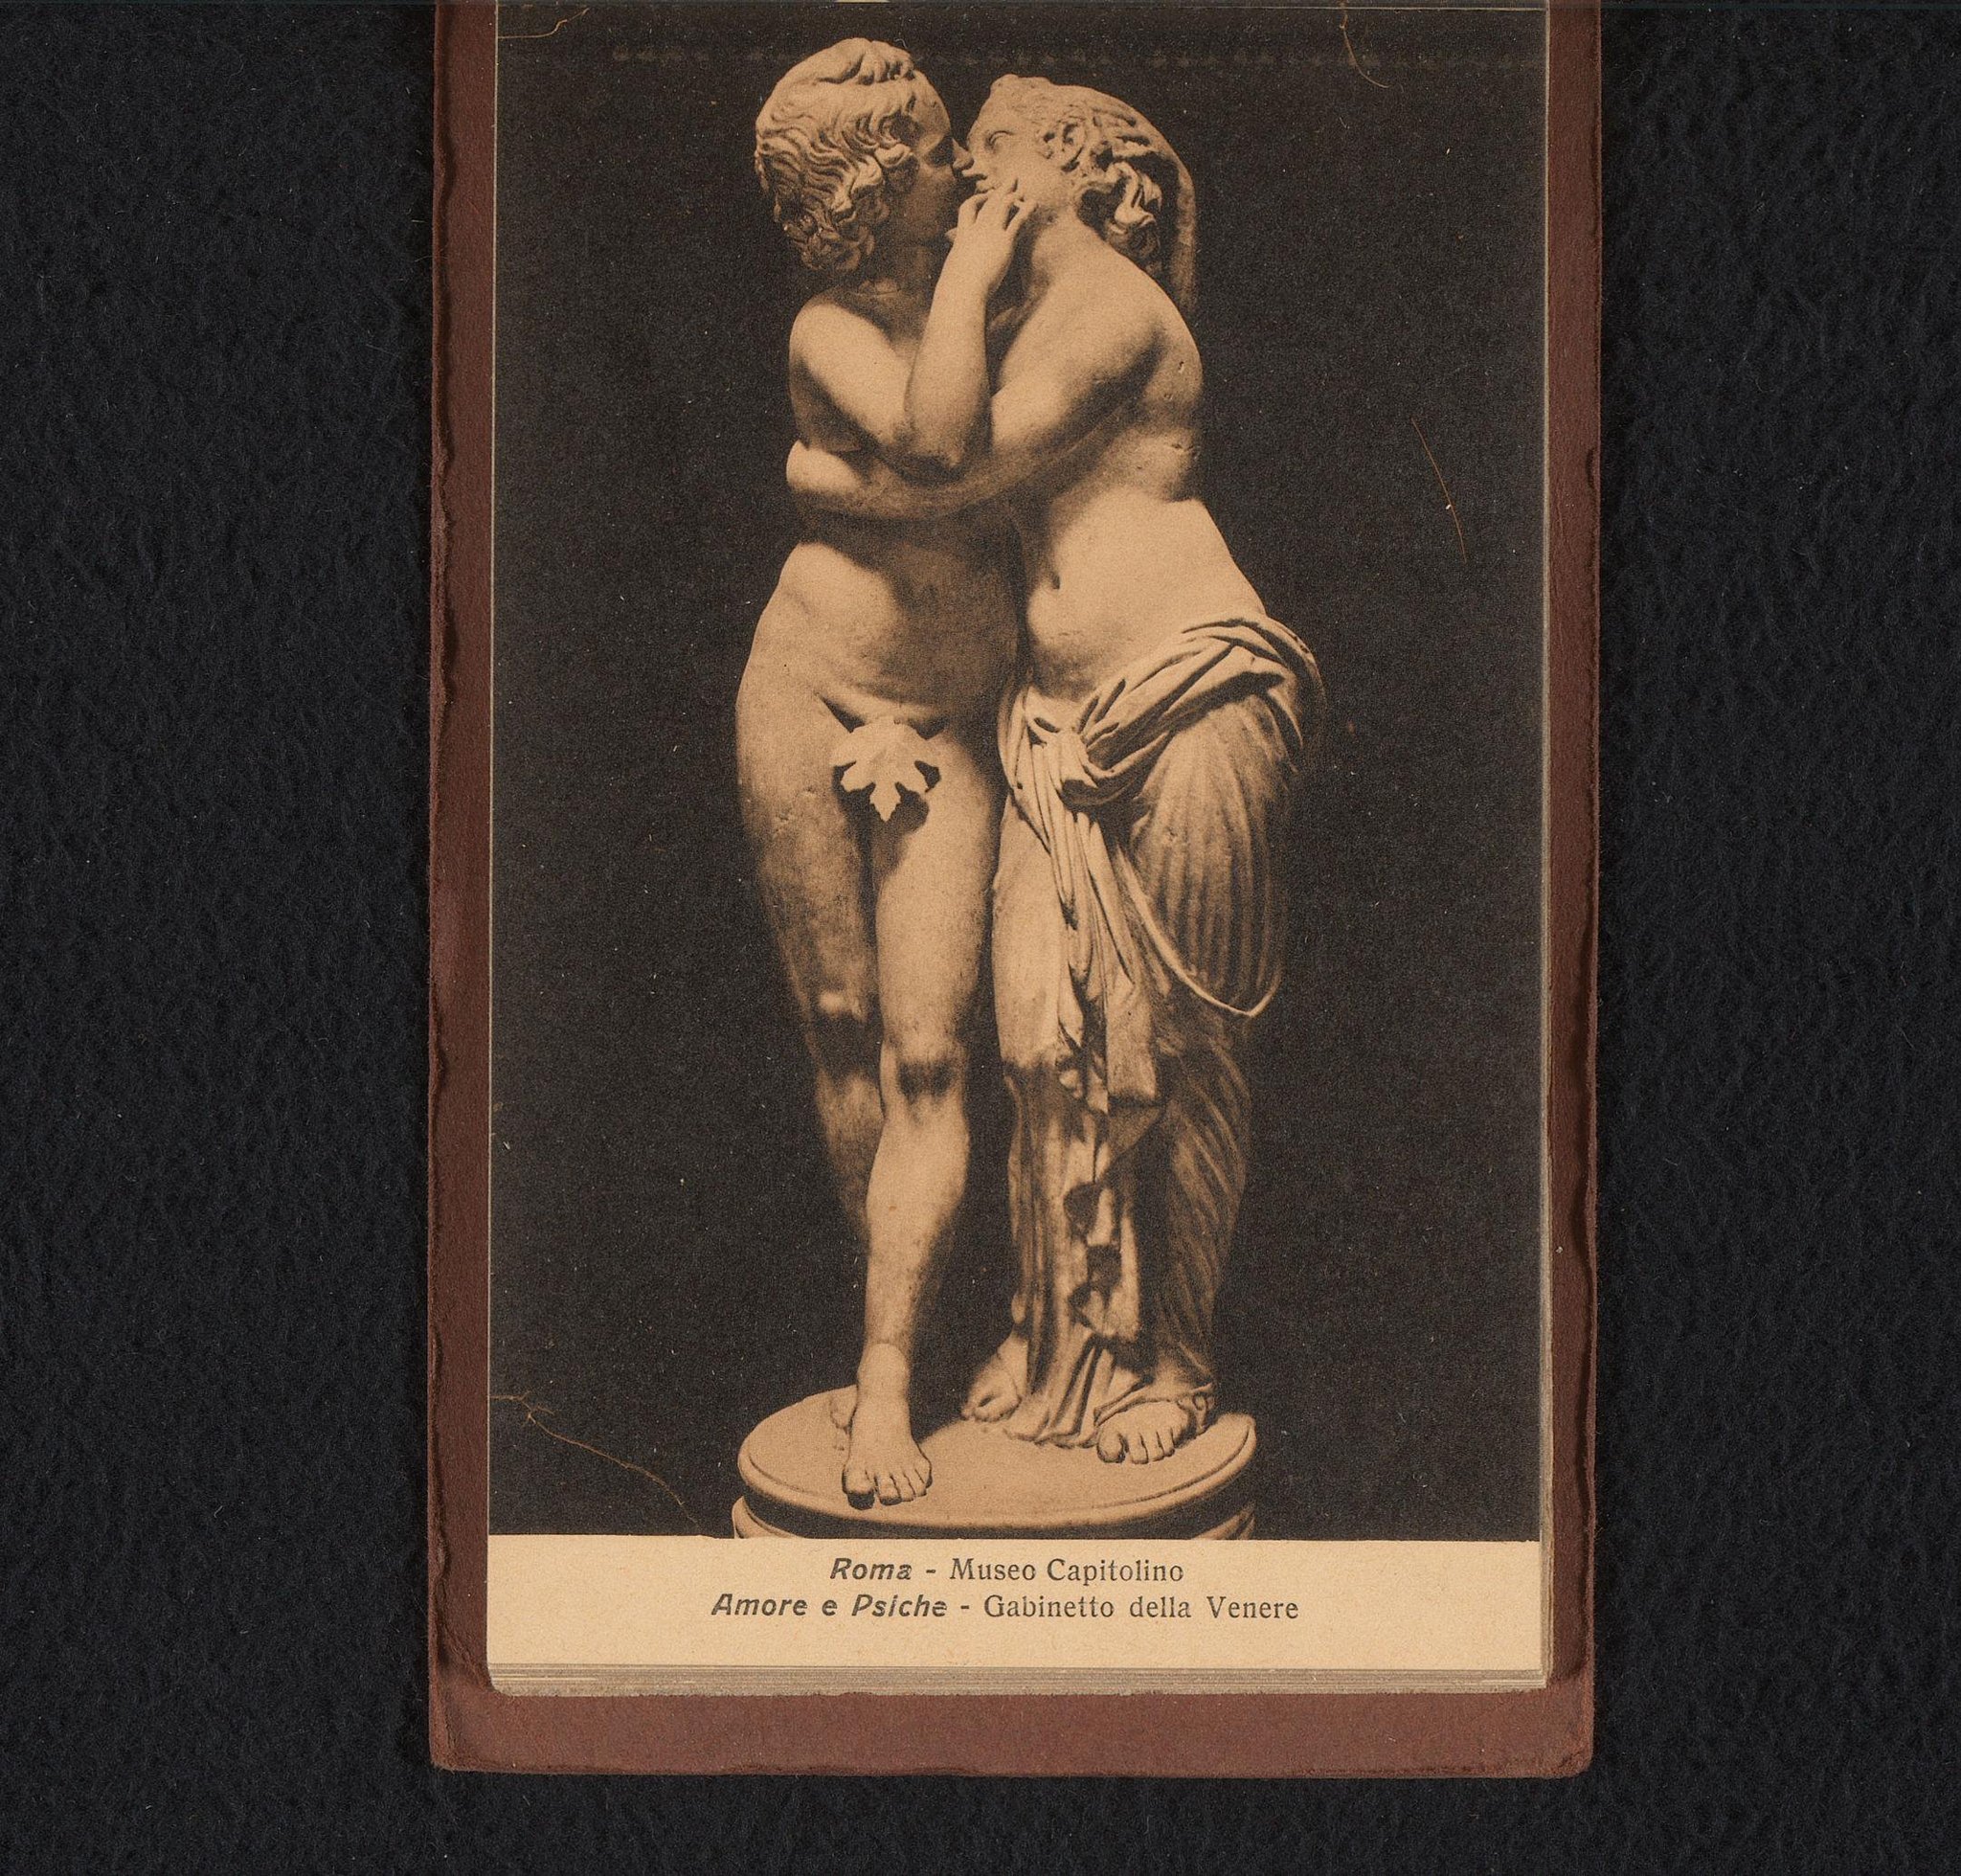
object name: ansichtkaart, prentbriefkaart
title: Roma - Museo Capitolino. Amore e Psiche - Gabinetto della Venere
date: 1905-1930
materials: cardboard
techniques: photograph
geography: terni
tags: statues, paintings, etc. ~ objects of worship in roman religion, permanent exhibition, museum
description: Prentbriefkaart maakt deel uit van een album.